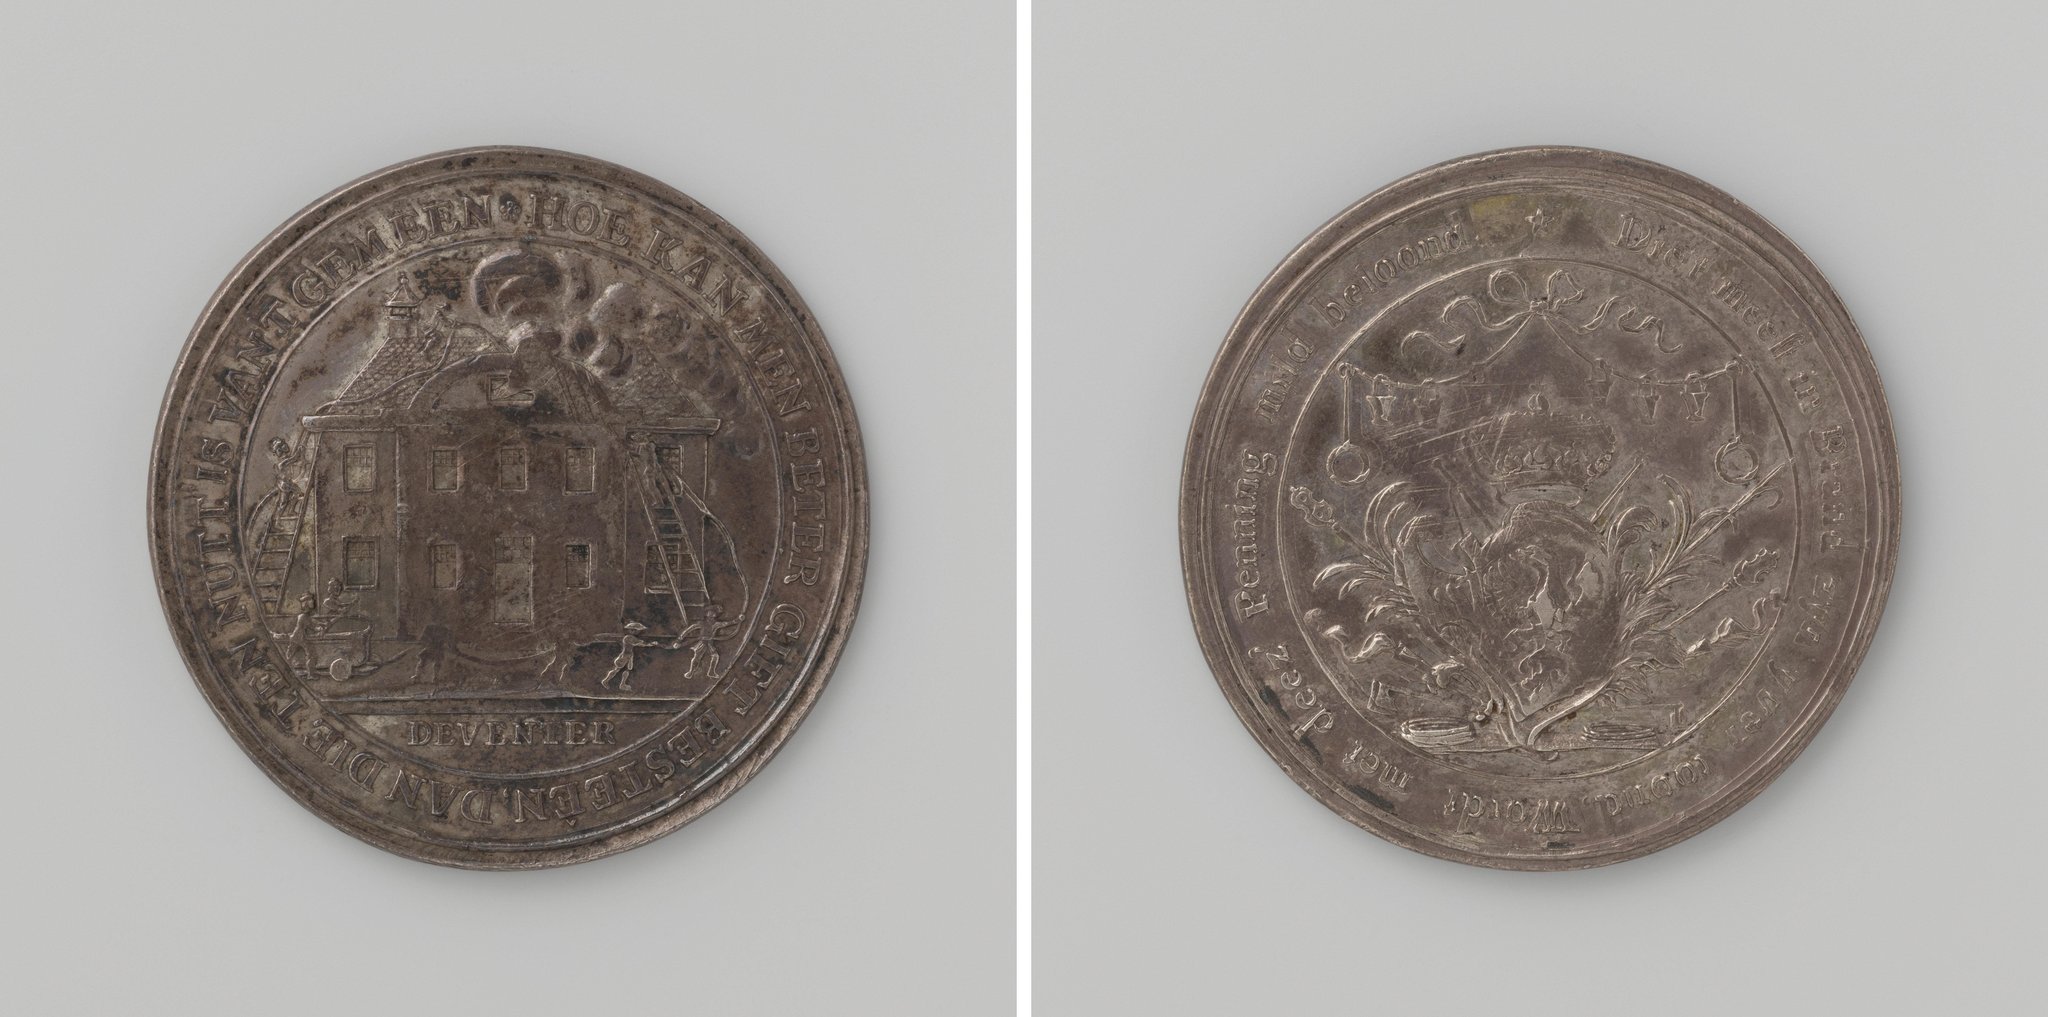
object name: fire engine medal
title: Deventer, brandspuitpenning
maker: Anonymous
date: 1680-1800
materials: silver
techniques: striking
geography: deventer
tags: deventer